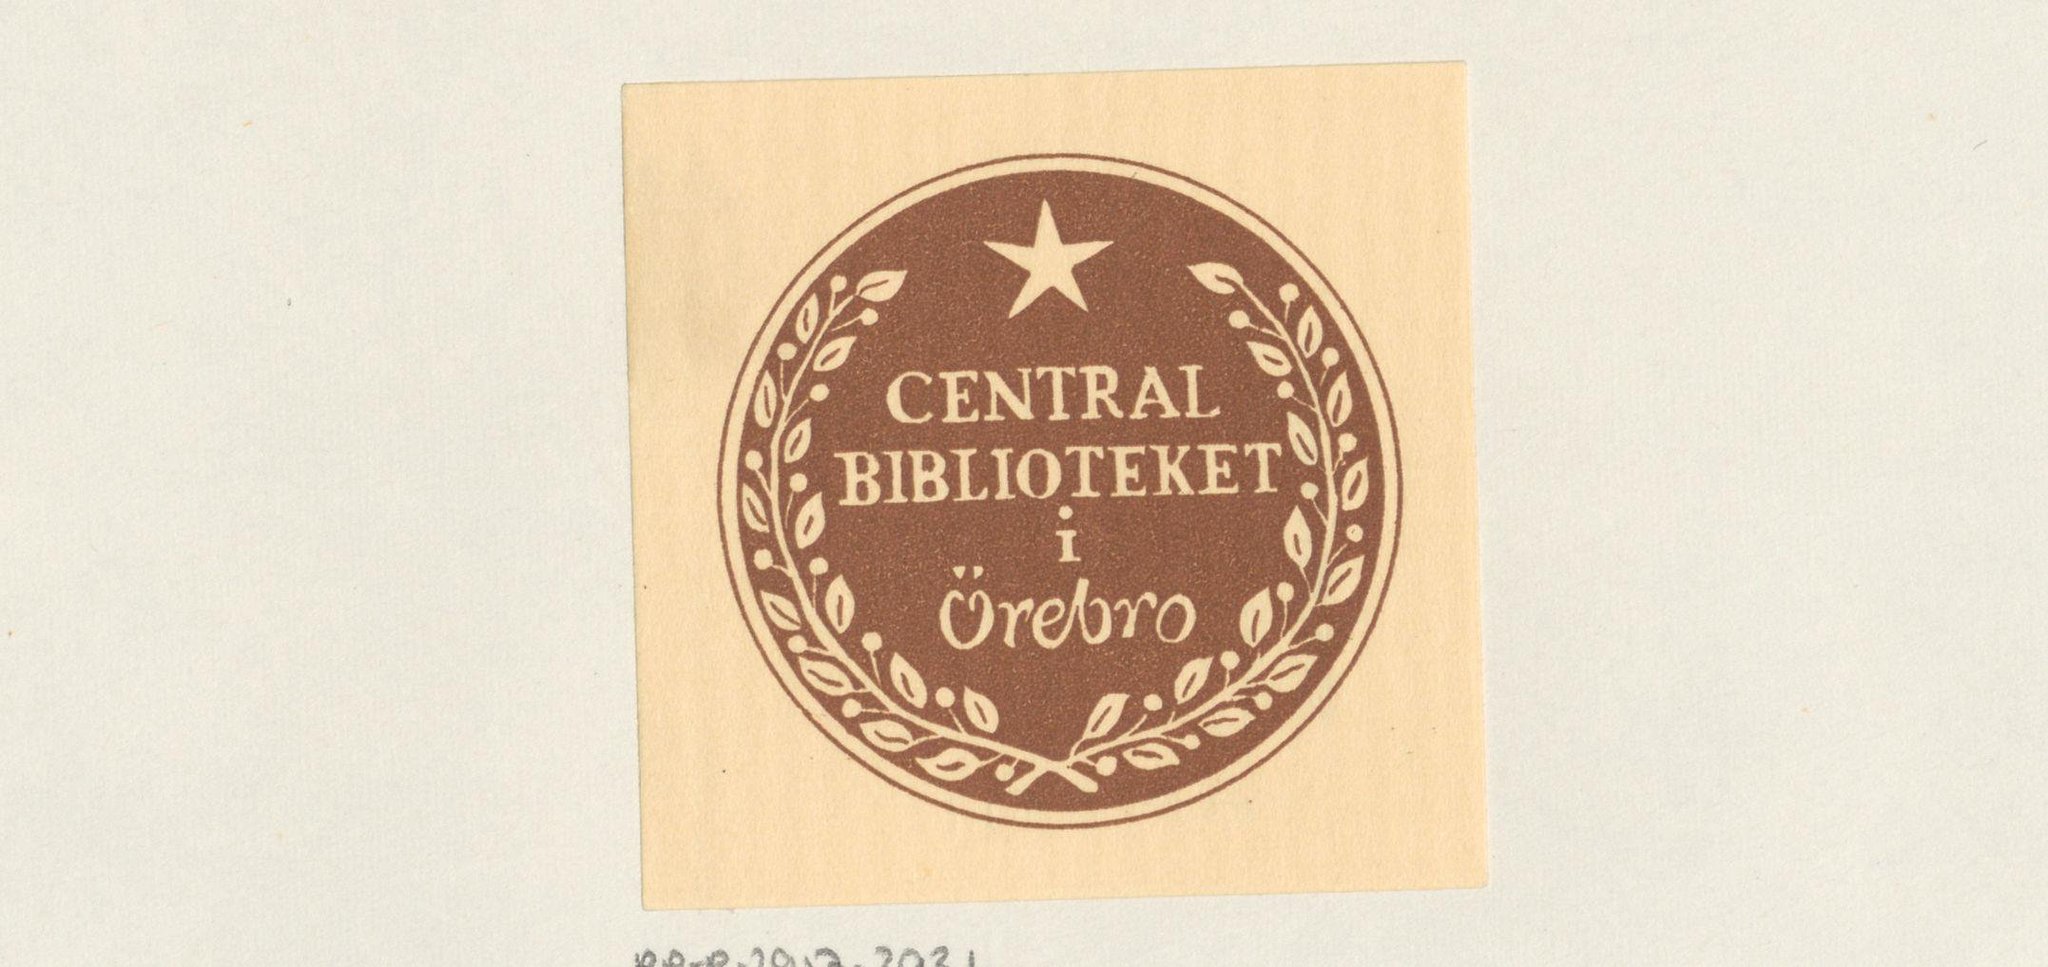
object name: bookplate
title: Ex libris van de Central Biblioteket i Örebro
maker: Anonymous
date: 1937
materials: paper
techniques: printing block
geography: orebro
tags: garland, wreath, stars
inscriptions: collector's mark: ‘Ex libris collection / Kristen Rasmussen’